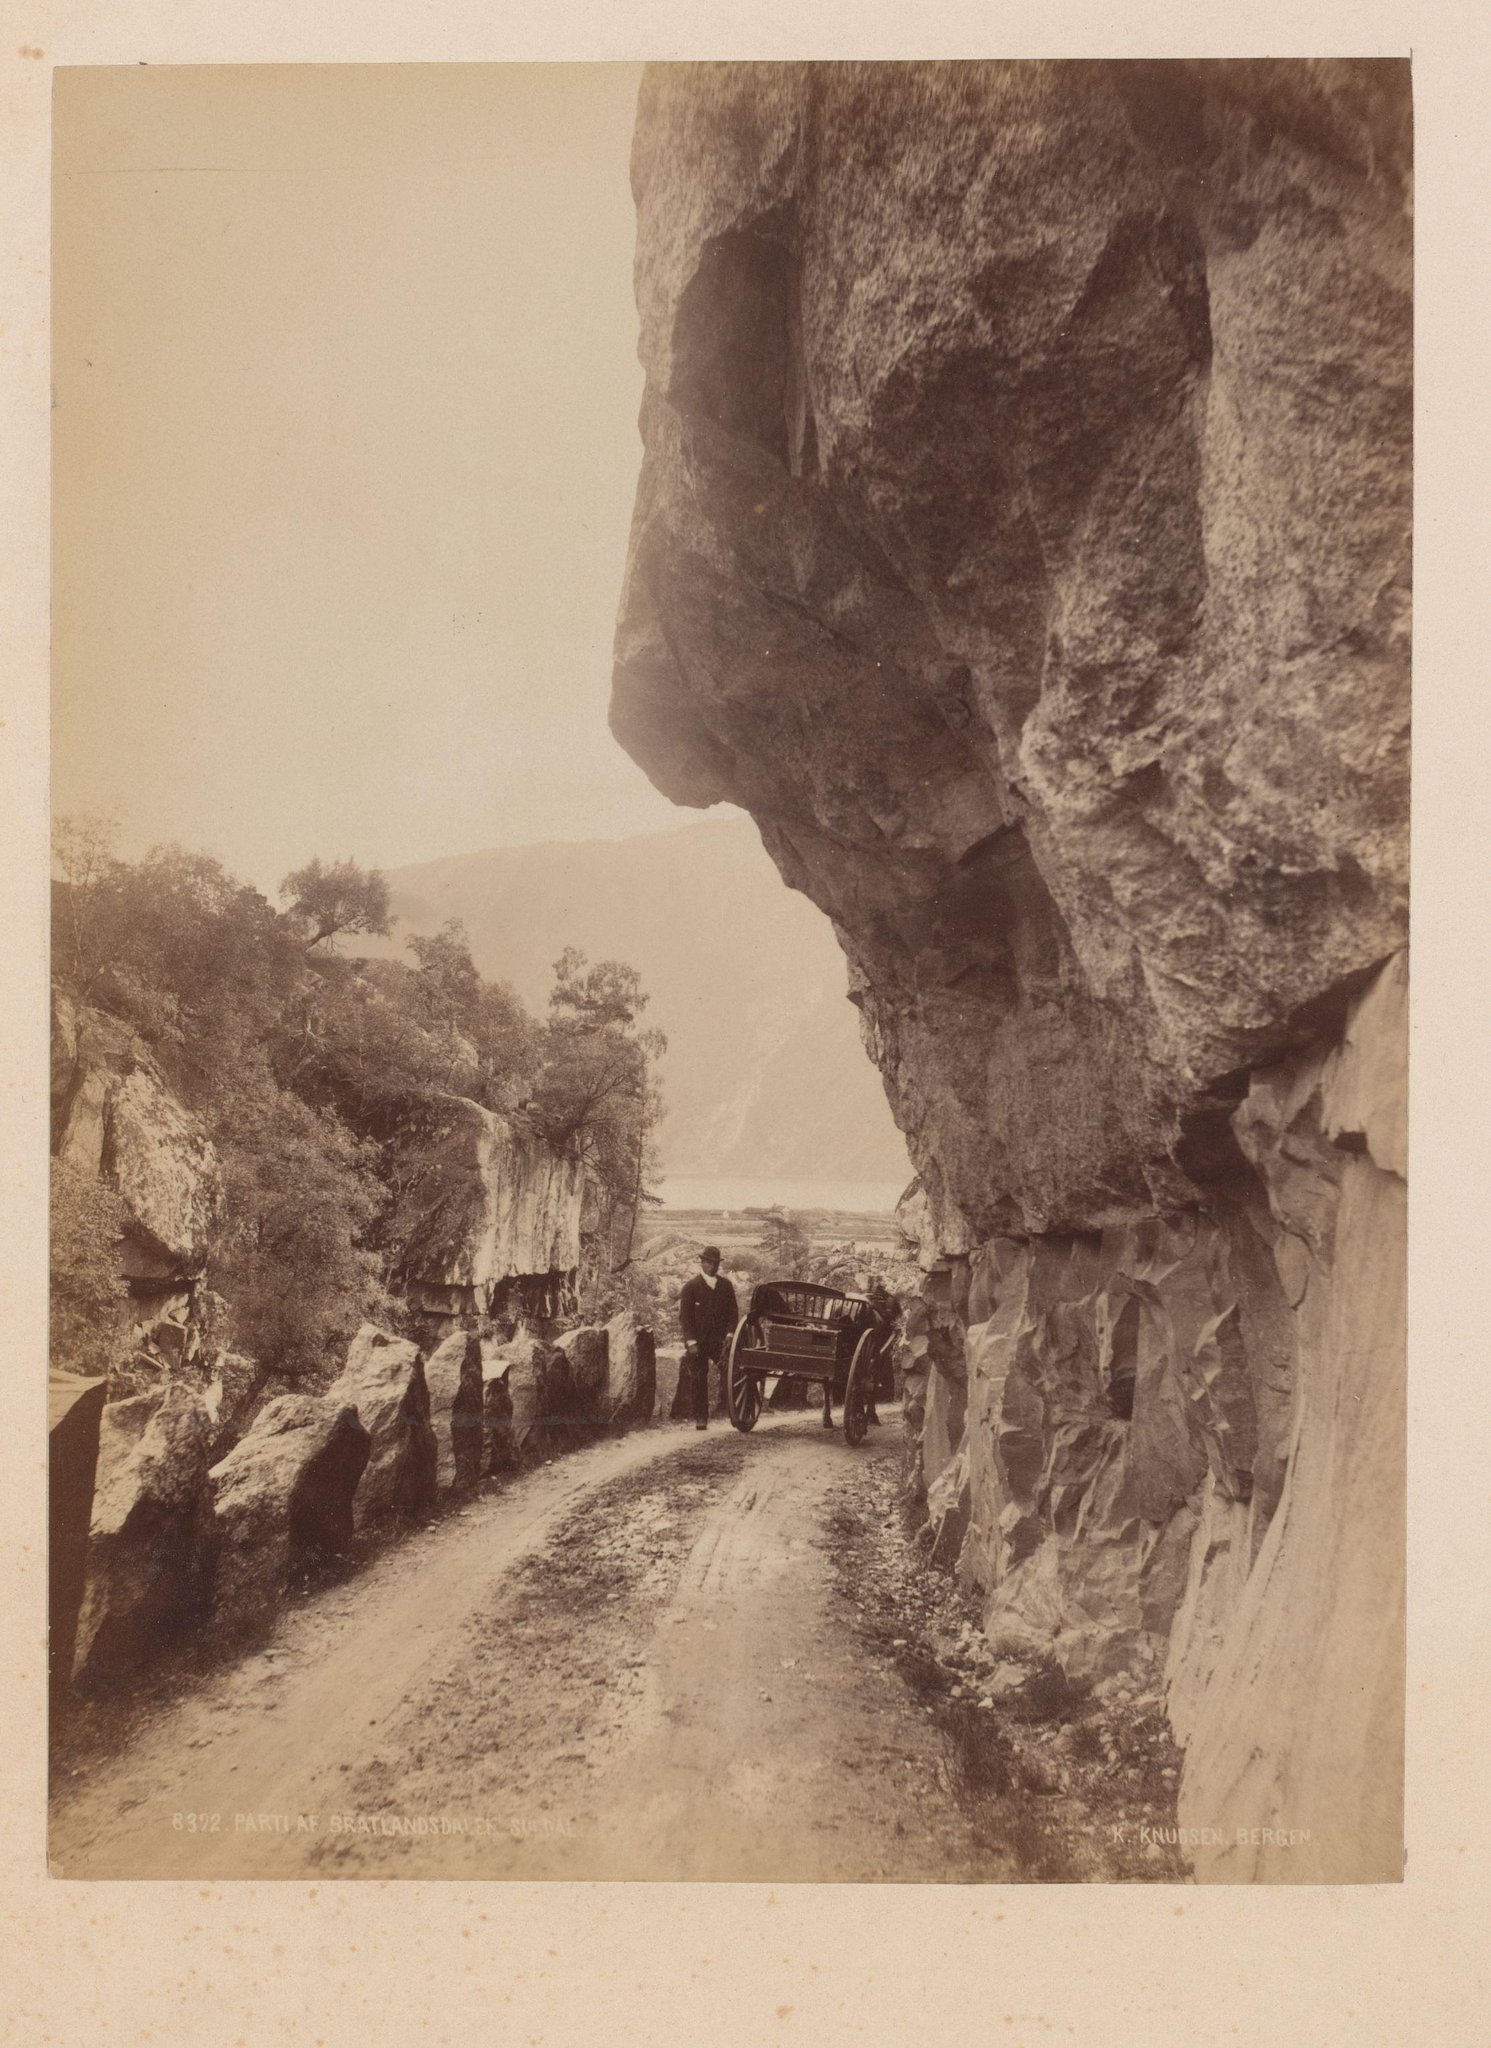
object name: photograph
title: Parti af Bratlandsdalen, Suldal, Noorwegen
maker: knud knudsen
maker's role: fotograaf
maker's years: 1832-1915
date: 1870-1900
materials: cardboard, photographic support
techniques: albumen print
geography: norway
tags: norway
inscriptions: number: ‘K. Knudsen, Bergen’, caption: ‘3375 PARTI AF BRATLANDSDALEN SULDAL’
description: Overhangende rots met daaronder een weg met een man met paard en wagen. Suldal is een gemeente in de Noorse provincie Rogaland.